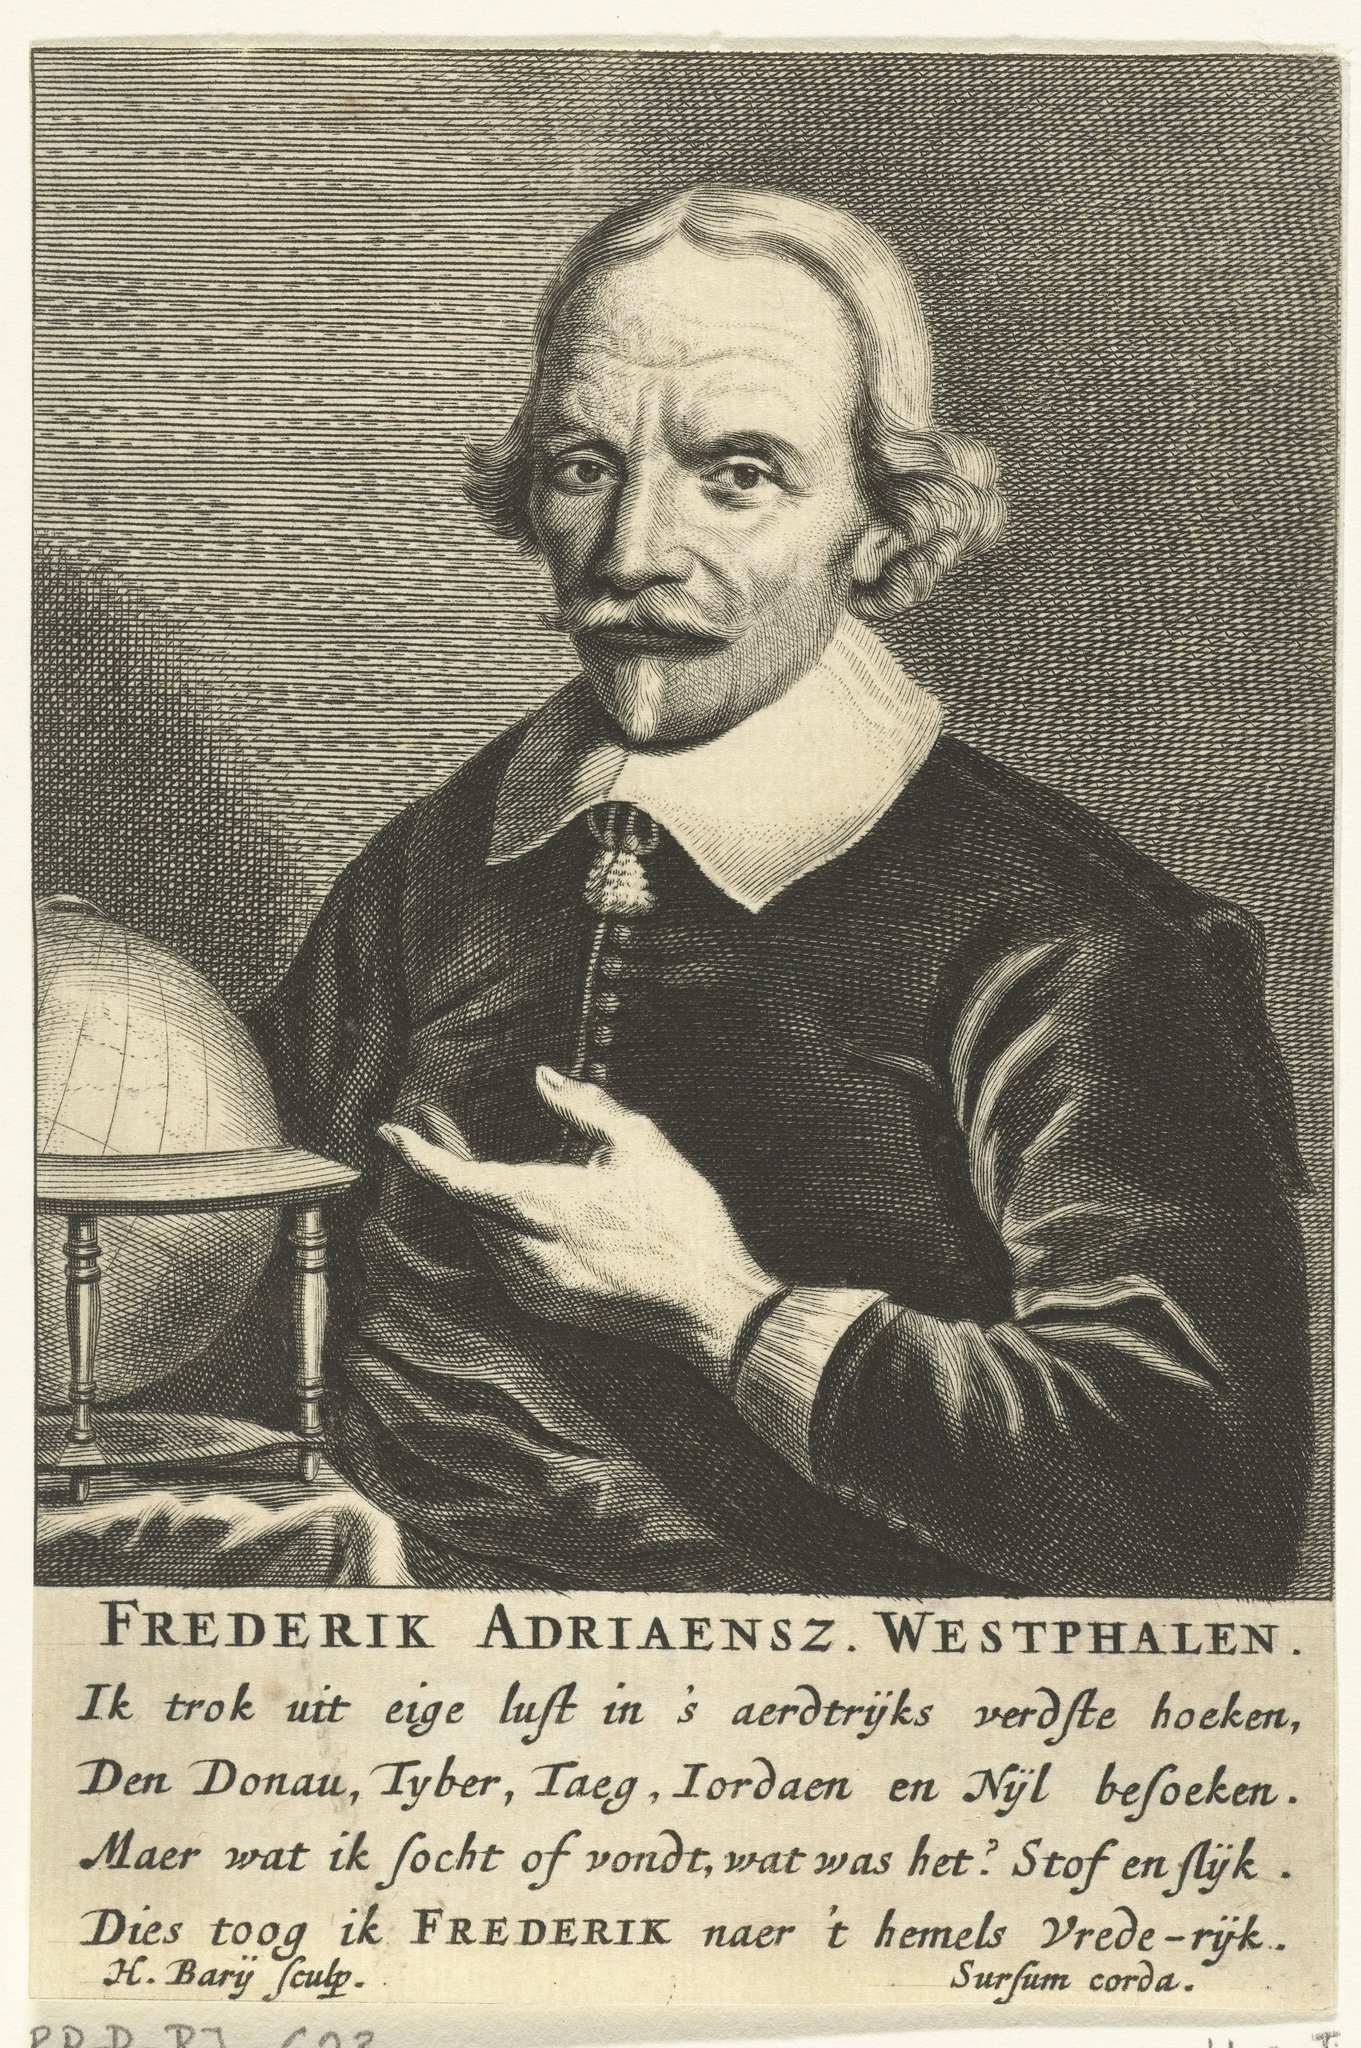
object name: print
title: Portret van Frederik Adriaensz. Westphalen op 72-jarige leeftijd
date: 1657-1707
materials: paper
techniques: engraving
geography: netherlands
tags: enkhuizen, traveler, globe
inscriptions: collector's mark: Lugt 240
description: Portret van Frederik Adriaensz. Westphalen (1581-1653) op 72-jarige leeftijd, naast hem een globe. Onder het portret een vers van vier regels in het Nederlands door G. Brandt getekend: Sursum Corda.